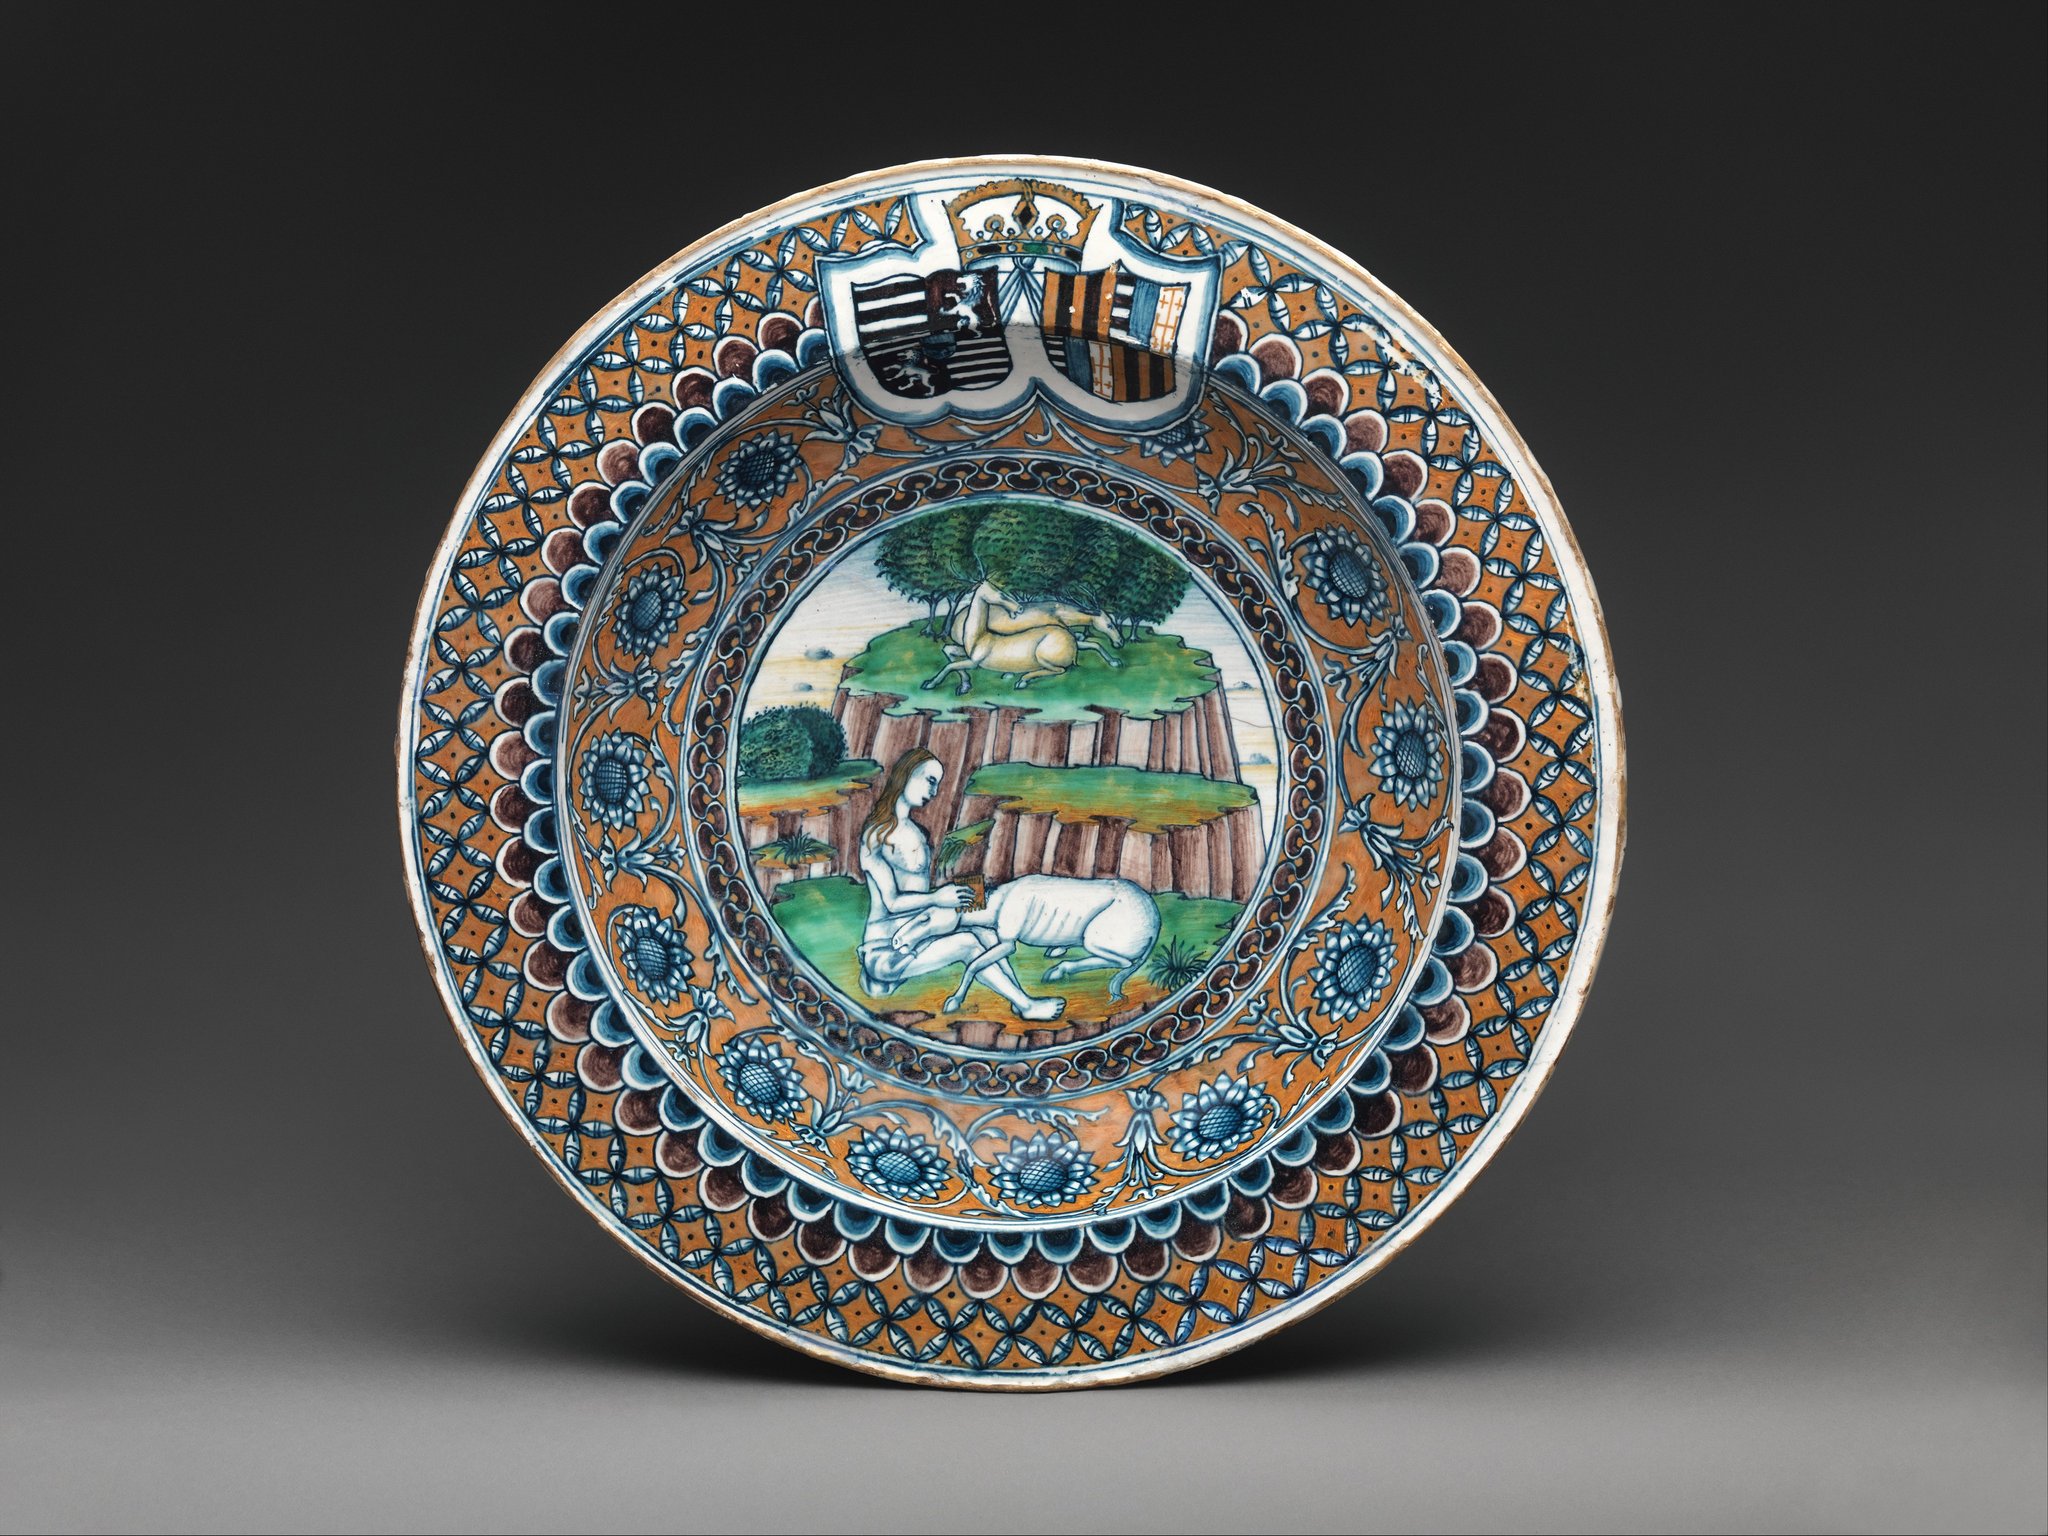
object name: bowl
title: Bowl with The Virgin and the Unicorn and arms of Matthias Corvinus and Beatrice of Aragon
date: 1486-1488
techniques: maiolica, glazing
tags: unicorns,virgin mary,coat of arms